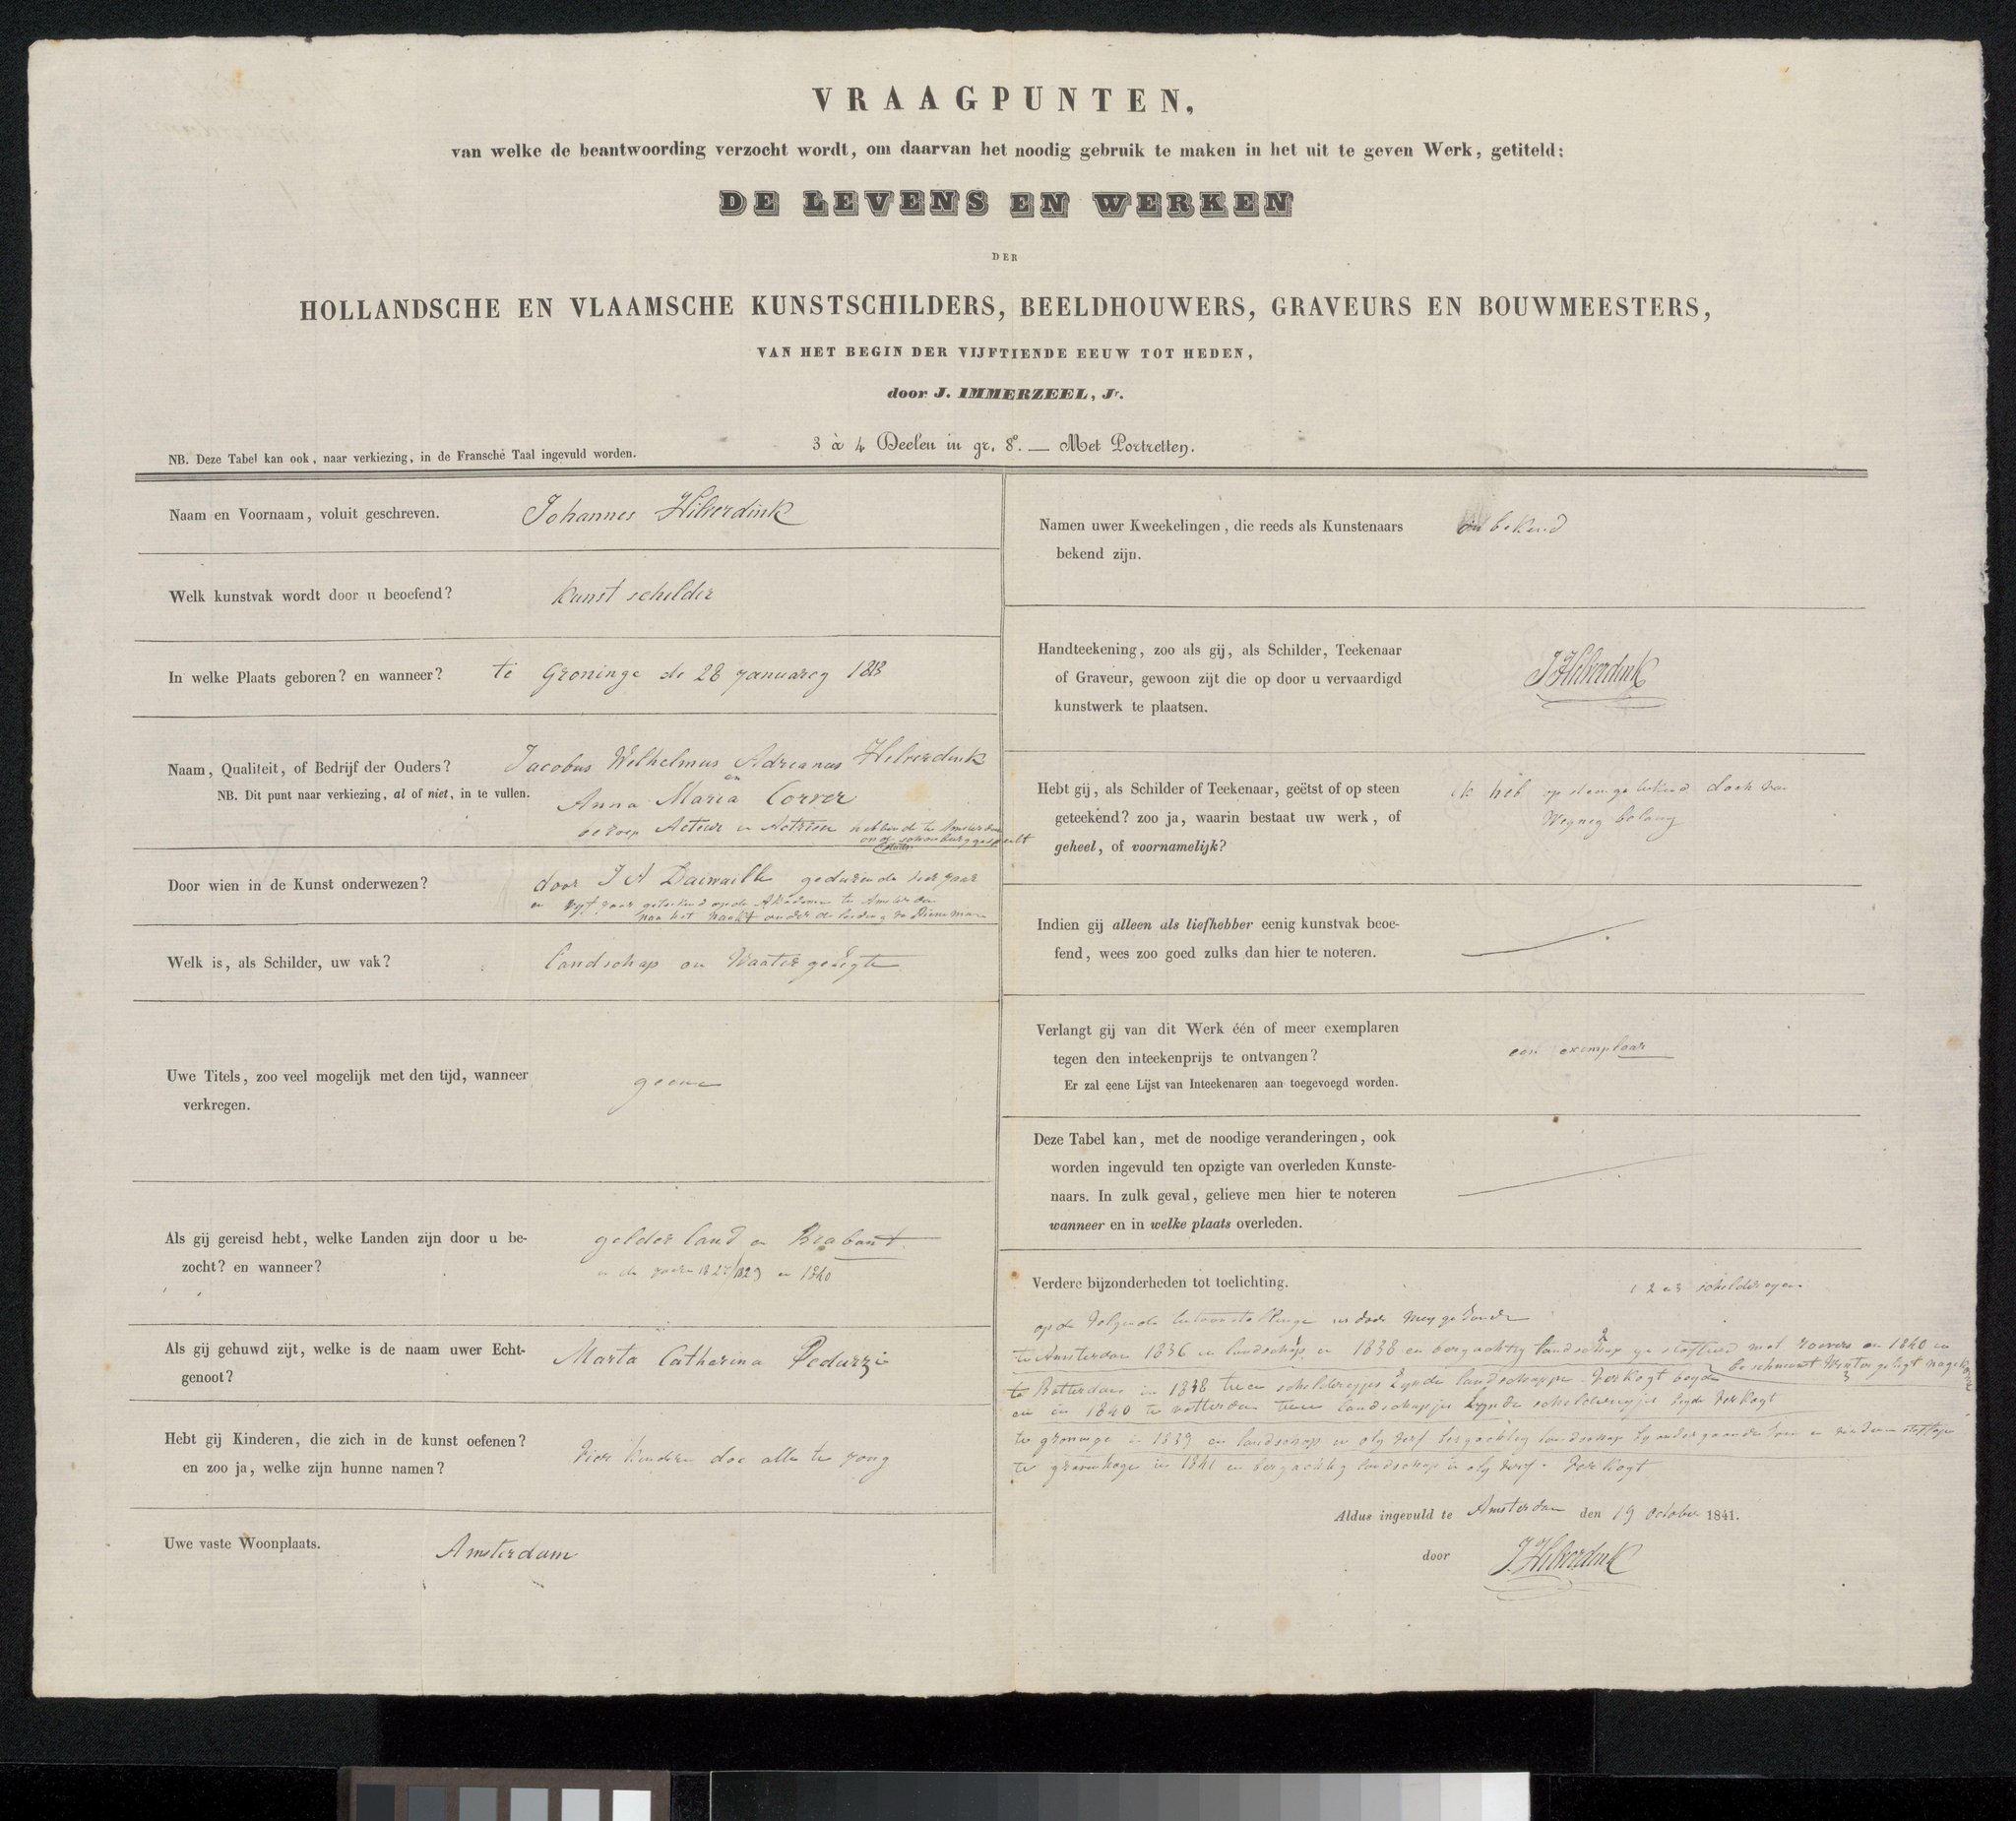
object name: manuscript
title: Enquêteformulier ingevuld door Johannes Hilverdink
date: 1841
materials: ink, paper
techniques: pen, printing, writing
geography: amsterdam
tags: amsterdam, painter, print maker, draughtsman, johannes hilverdink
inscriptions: watermark, inscription: ‘Vraagpunten,/ van welke de beantwoording verzocht wordt, om daarvan het noodig gebruik te maken in het uit te geven Werk, getiteld: De levens en werken/ der Hollandsche en Vlaamsche kunstschilders, beeldhouwers,/ graveurs en bouwmeesters, van het begin der vijftiende eeuw tot heden/ door J. Immerzeel, Jr.’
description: Opgenomen in: Immerzeel, J. Jr., De levens en werken der Hollandsche en Vlaamsche kunstschilders, beeldhouwers, graveurs en bouwmeesters, van het begin der vijftiende eeuw tot heden, Amsterdam: J.C. van Kesteren, 1842-1843.